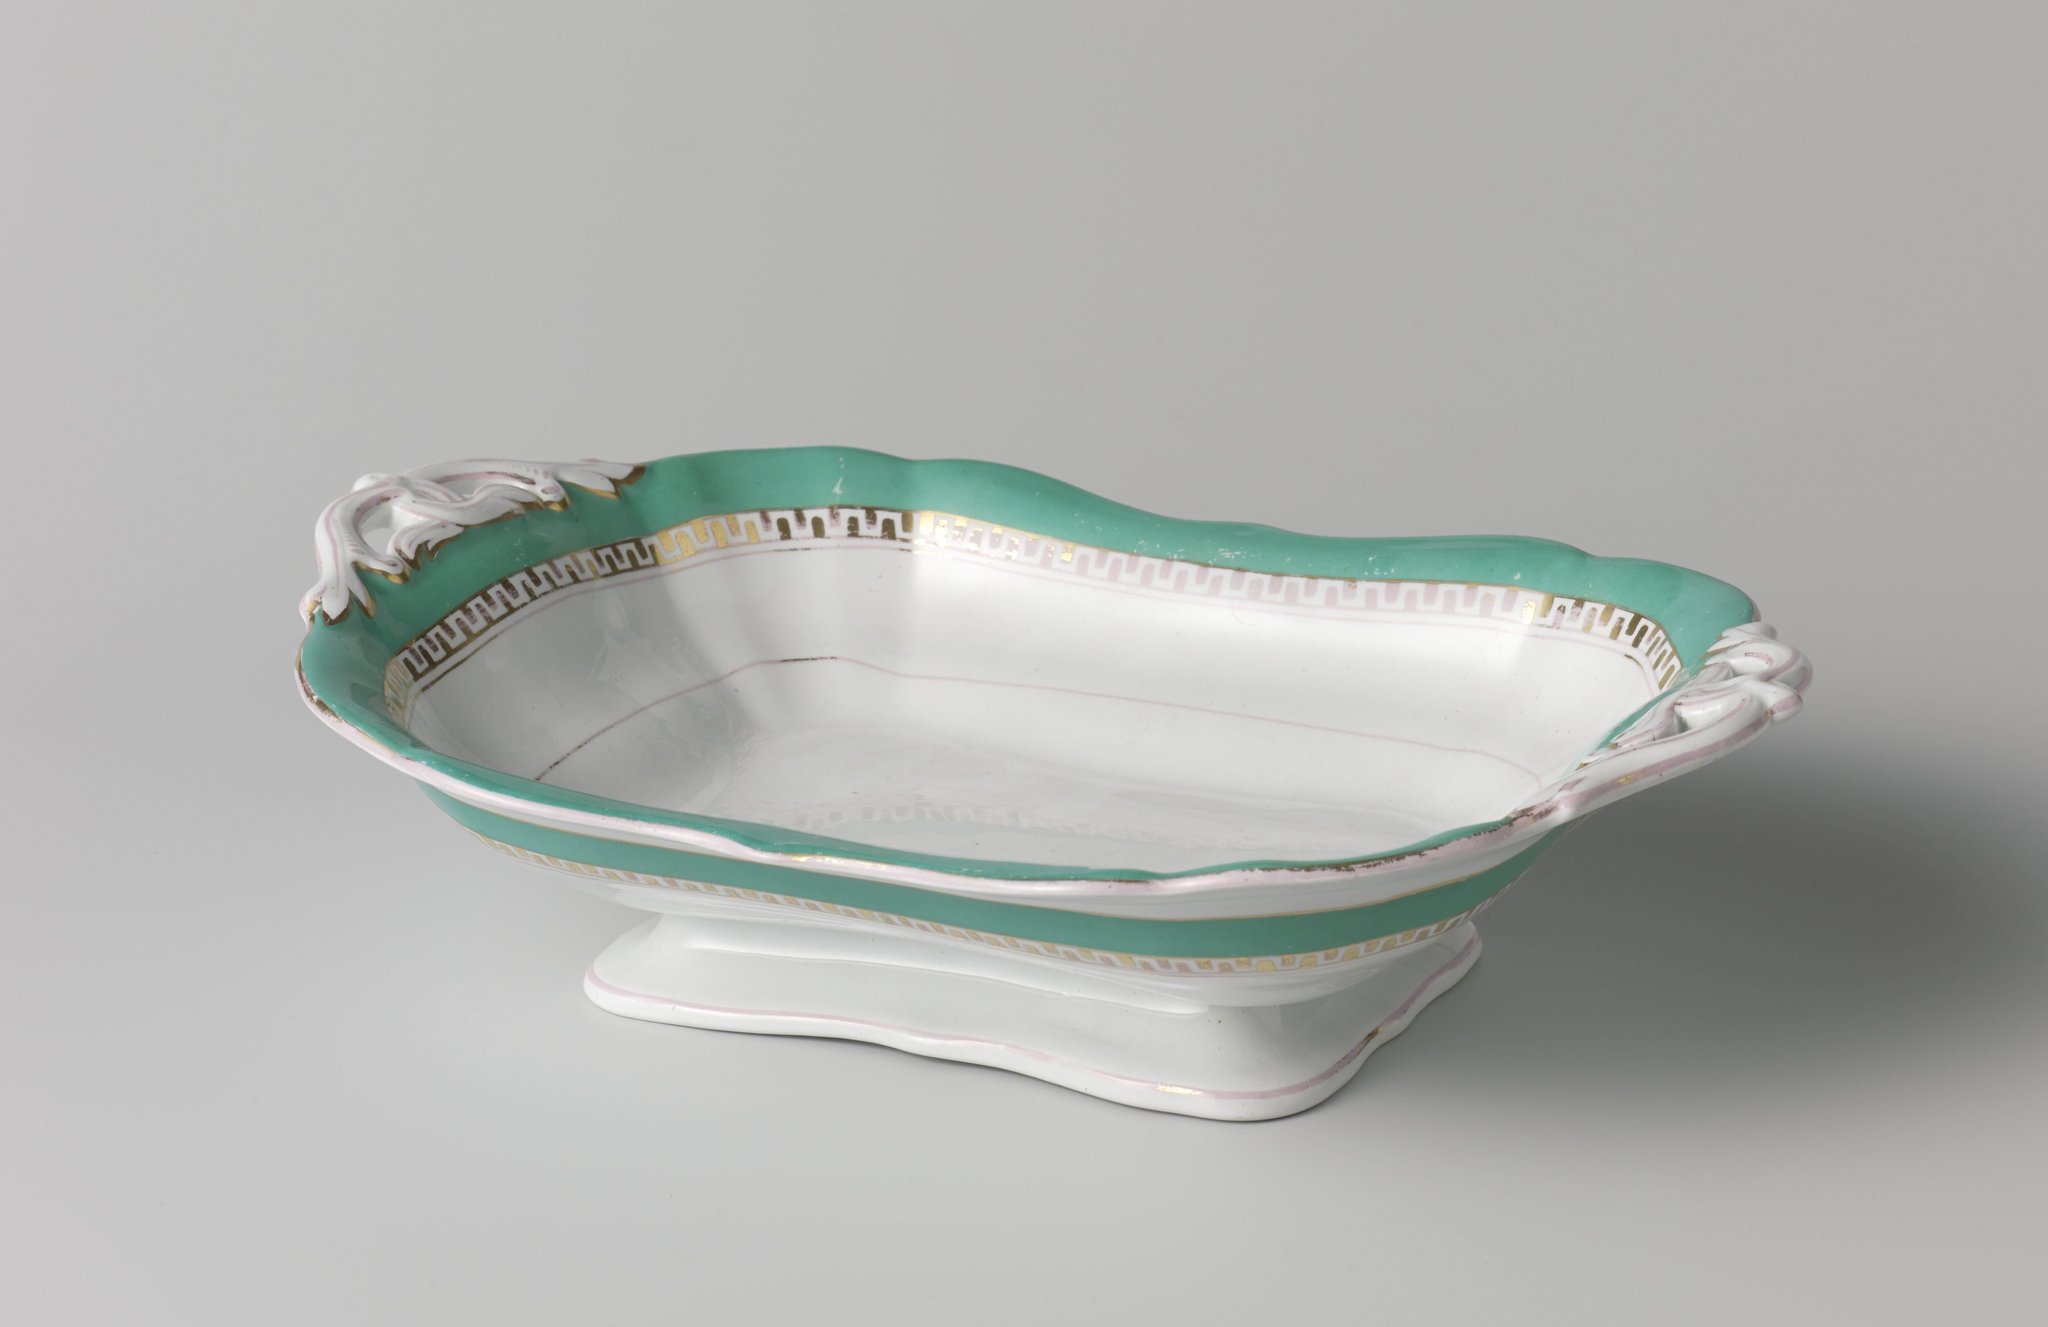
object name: dish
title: Schaal op voet, rechthoekig, met groene rand en gouden Griekse band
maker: petrus regout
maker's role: plateelbakker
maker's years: 1801-1879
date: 1865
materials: earthenware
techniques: transfer decoration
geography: maastricht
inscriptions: check stamp: ‘P. REGOUT // MAASTRICHT // 2X 21’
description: Schaal op voet van aardewerk, rechthoekig, geschulpt, met groene rand en gouden Griekse band.